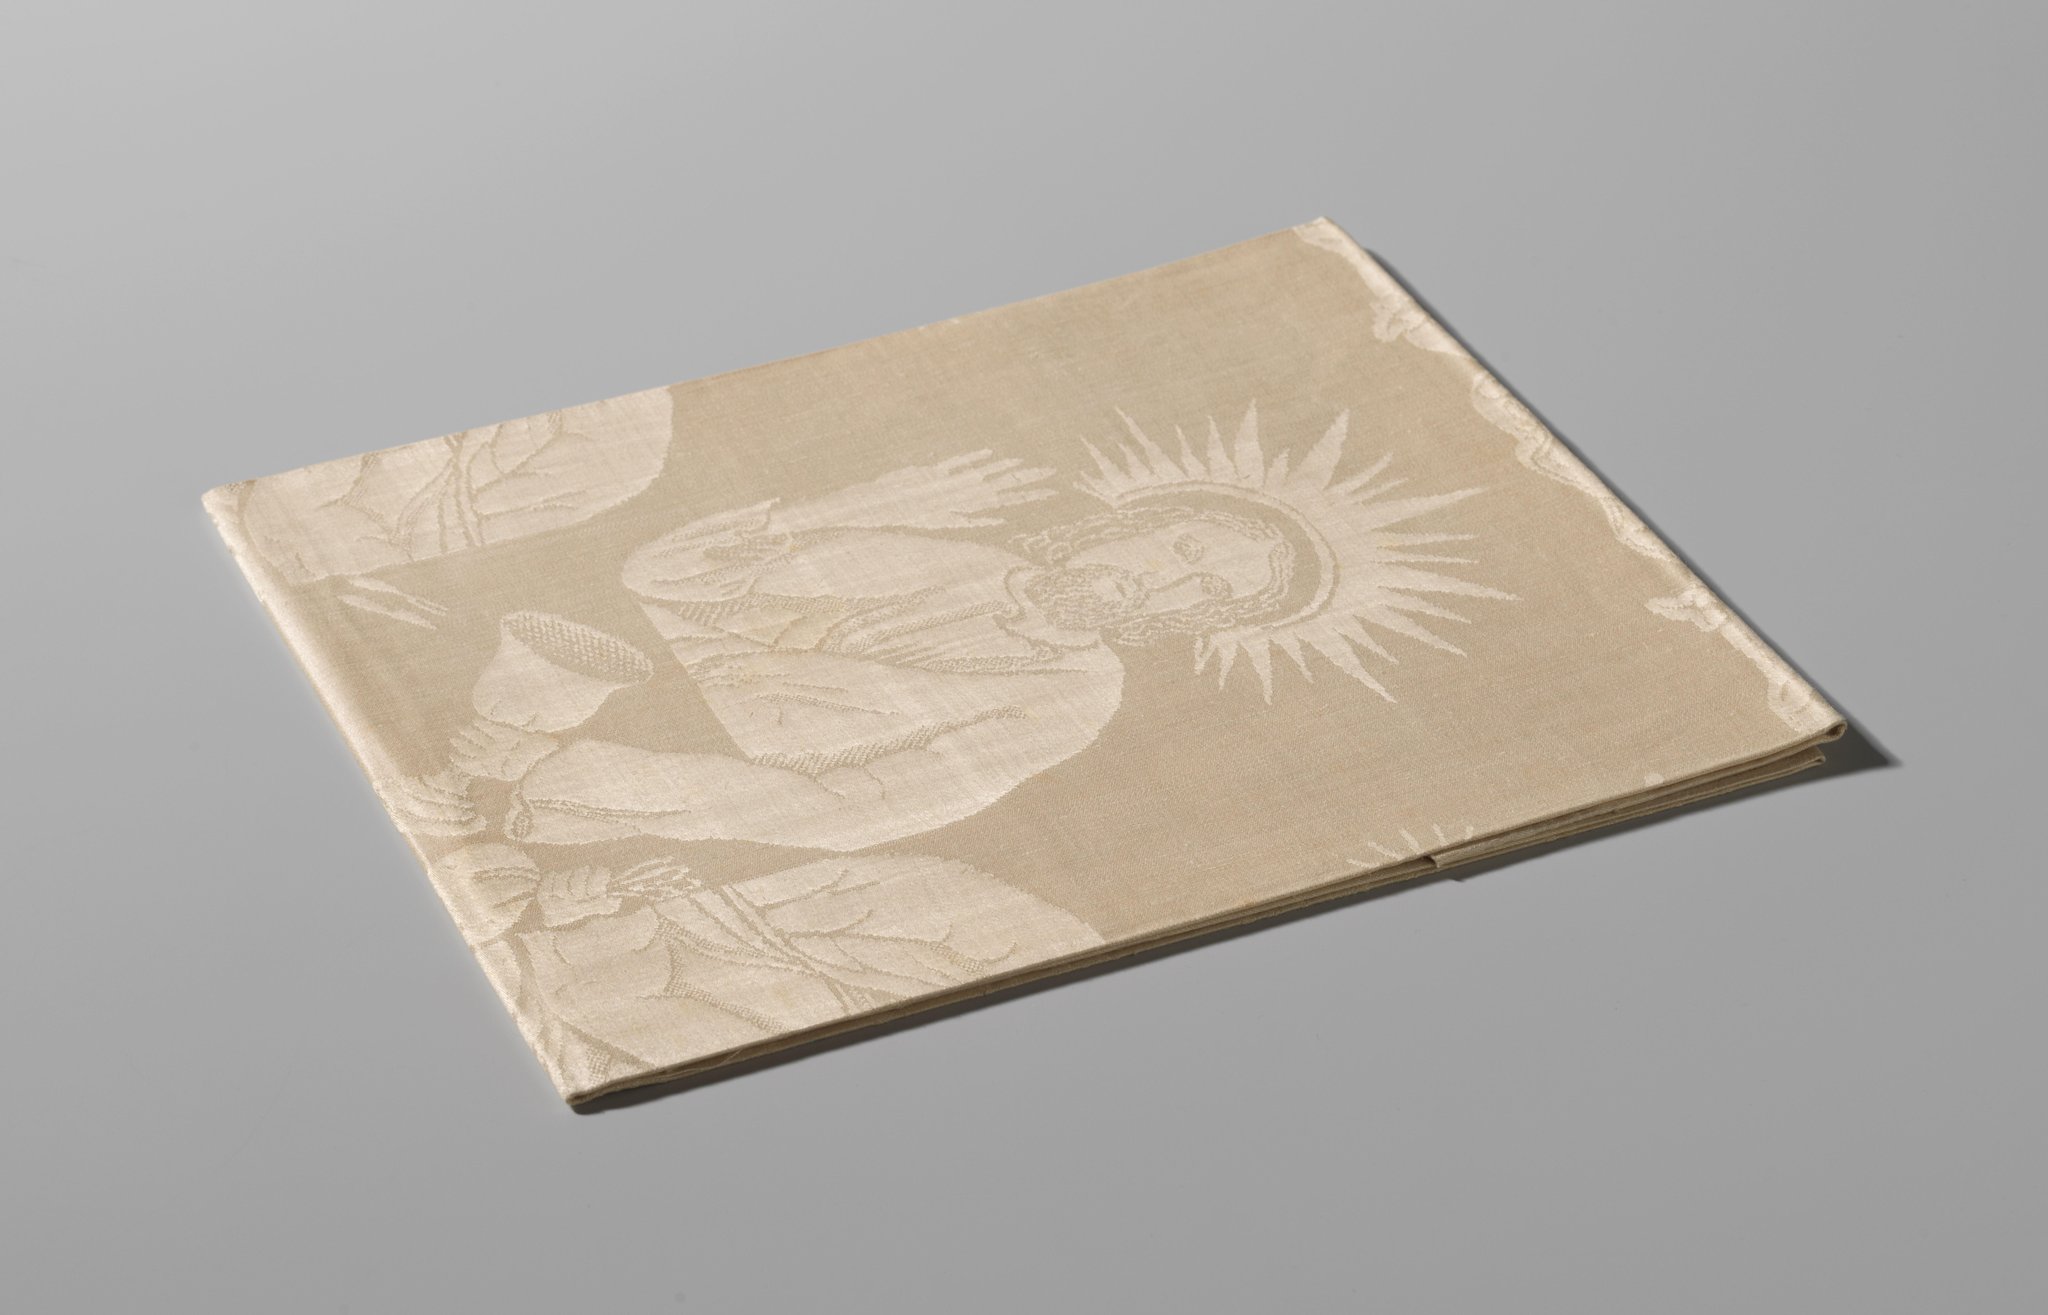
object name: napkin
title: Servet van wit linnendamast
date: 1859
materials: linen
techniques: damask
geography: borne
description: Wit linnen damasten servet met een voorstelling van het Laatste Avondmaal.